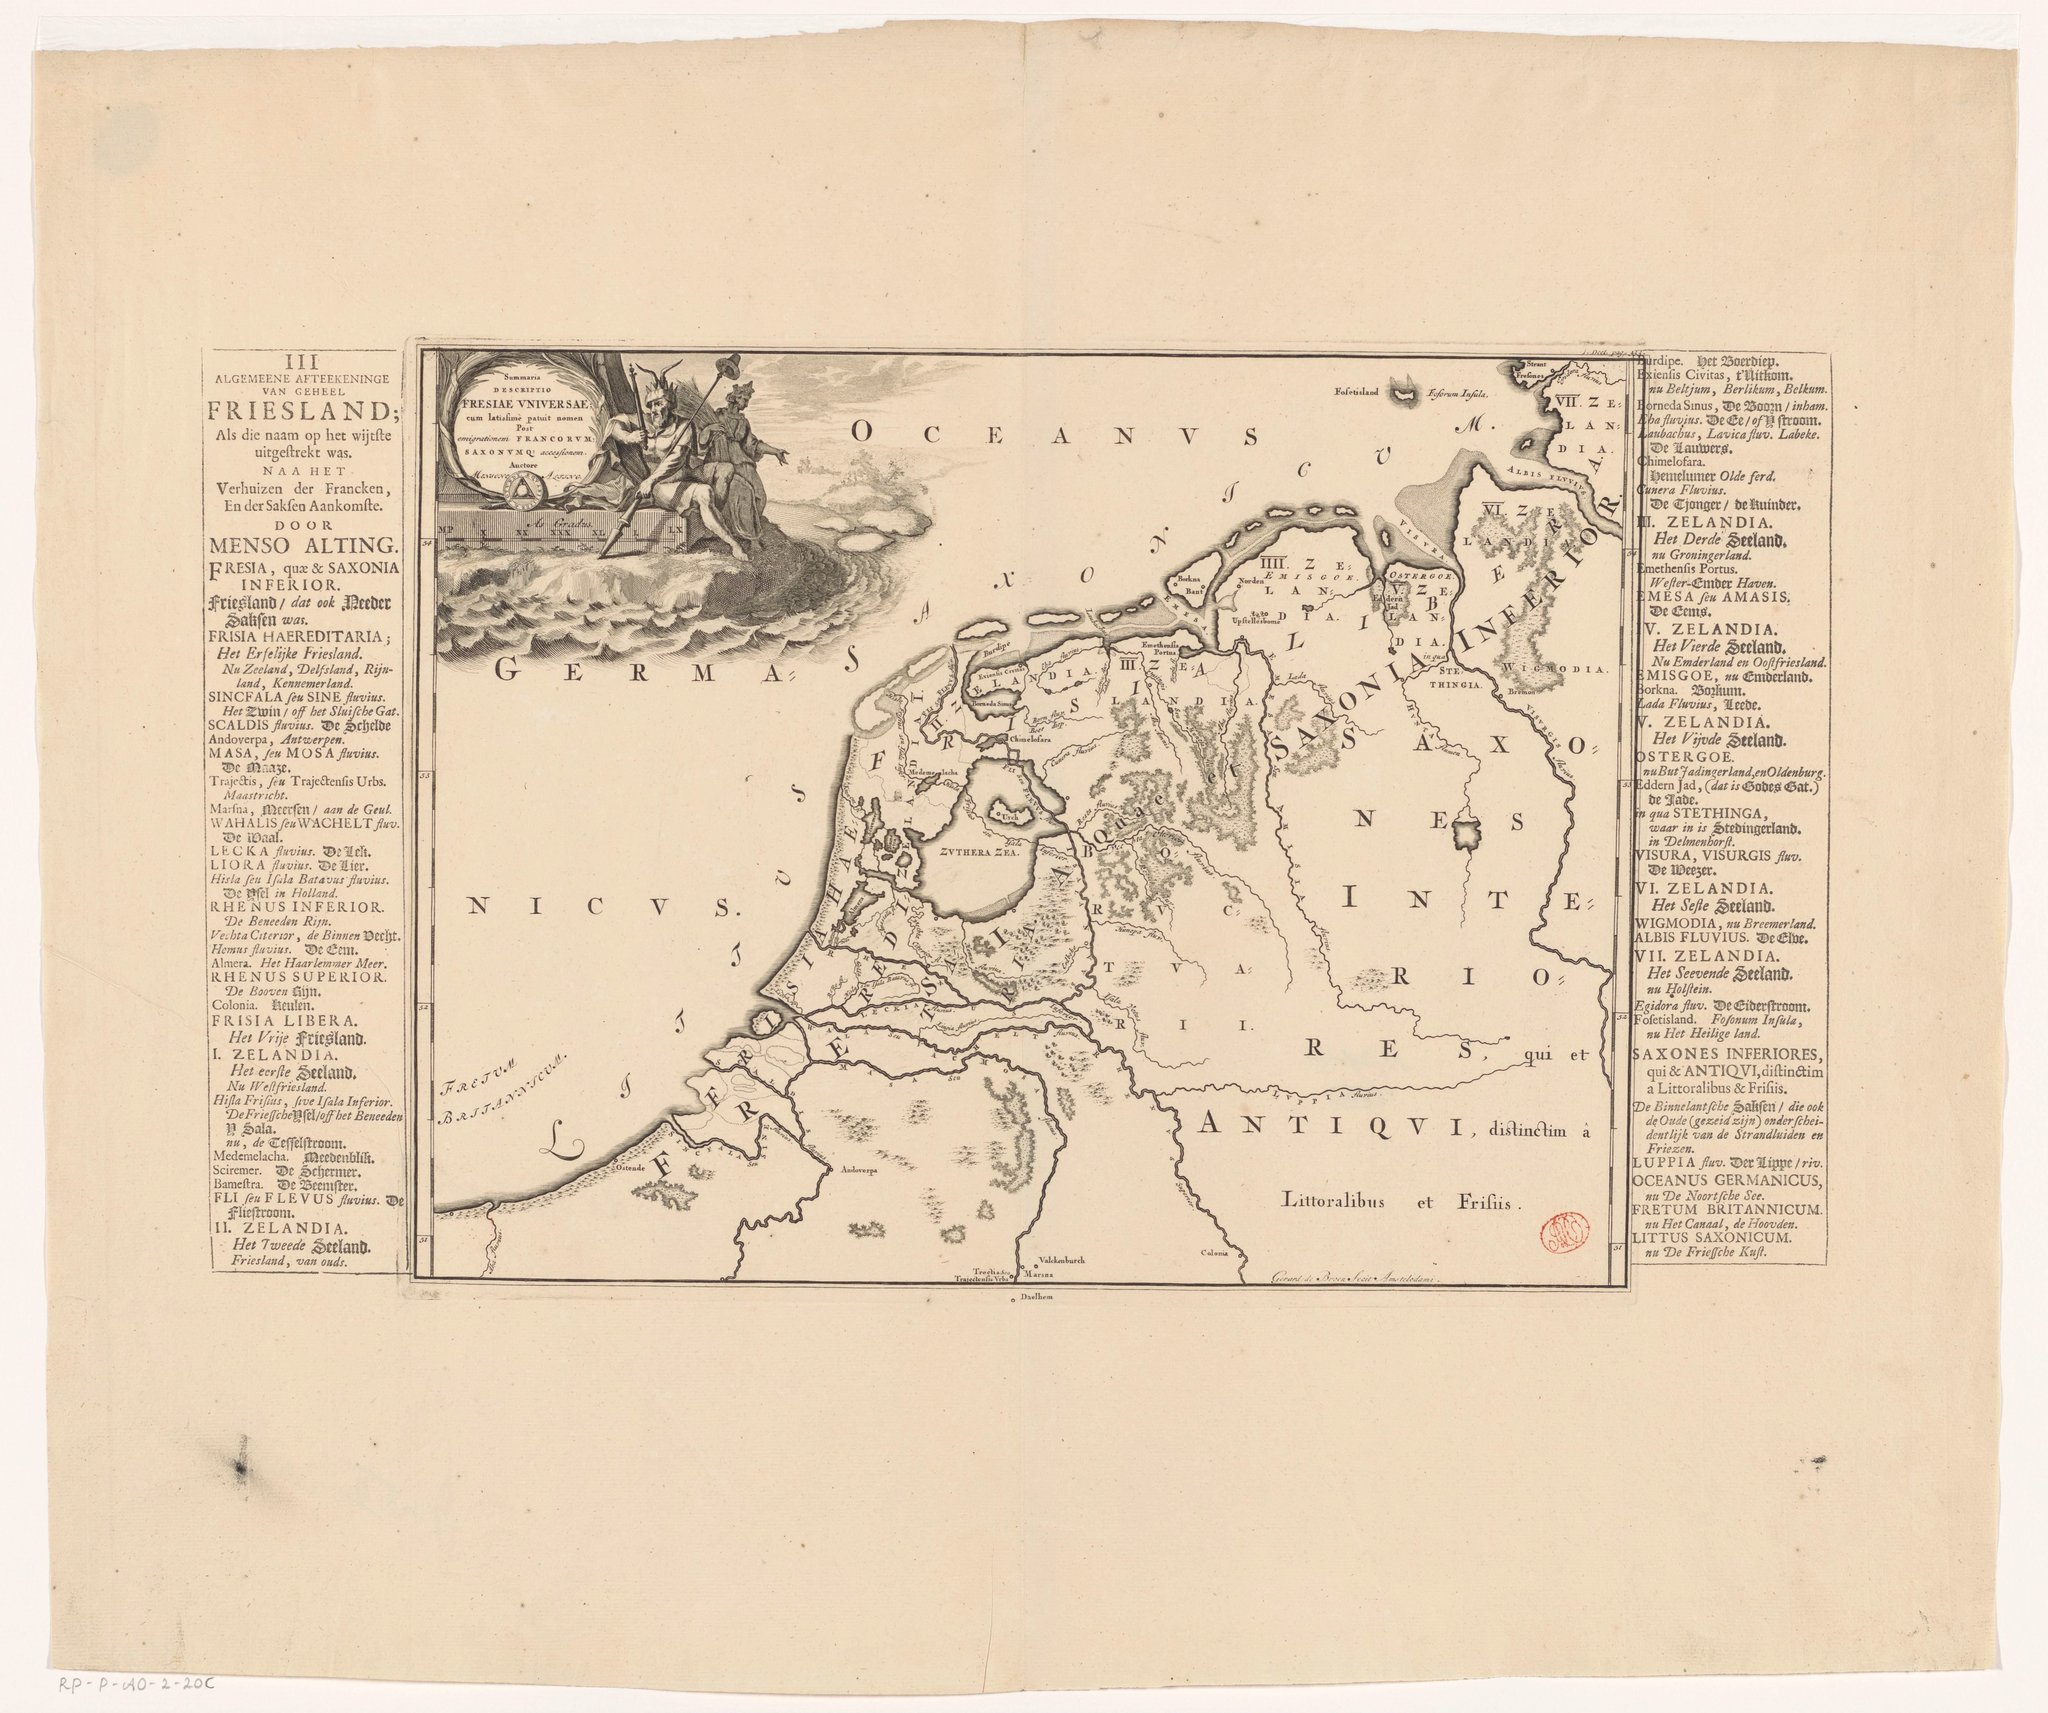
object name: map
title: Historische kaart van Nederland met de gebieden van de Bataven en Friezen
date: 1697-1700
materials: paper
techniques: engraving, etching, letterpress printing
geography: amsterdam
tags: maps of separate countries or regions, netherlands, germany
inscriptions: collector's mark: Lugt 195, collector's mark: Lugt 2228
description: Maakt deel uit van 16 kaarten van het land van de Bataven en de Friezen eerst vervaardigd voor en opgenomen in Alting, Menso. Descriptio, secundum antiquos, agri Batavi & Frisii. 2 delen. Amsterdam: Henricus Wetstein, 1697-1700. Hergebruikt in Halma, François. Tooneel der Vereenigde Nederlanden, en onderhorige landschappen (...). 2 delen. Leeuwarden: Hendrik Halma, 1725. Een deel van deze kaarten, waaronder dit exemplaar, is ook gebruikt in Schotanus à Sterringa, Bernardus. Uitbeelding der Heerlijkheit Friesland. Zoo int algemeen, als in haare XXX bijzondere grietenijen (...). Leeuwarden: François Halma, 1718. Deze kaart is gebruikt in Halma's Tooneel der Vereenigde Nederlanden (1725) en is waarschijnlijk te vinden in deel 1, p. 333.